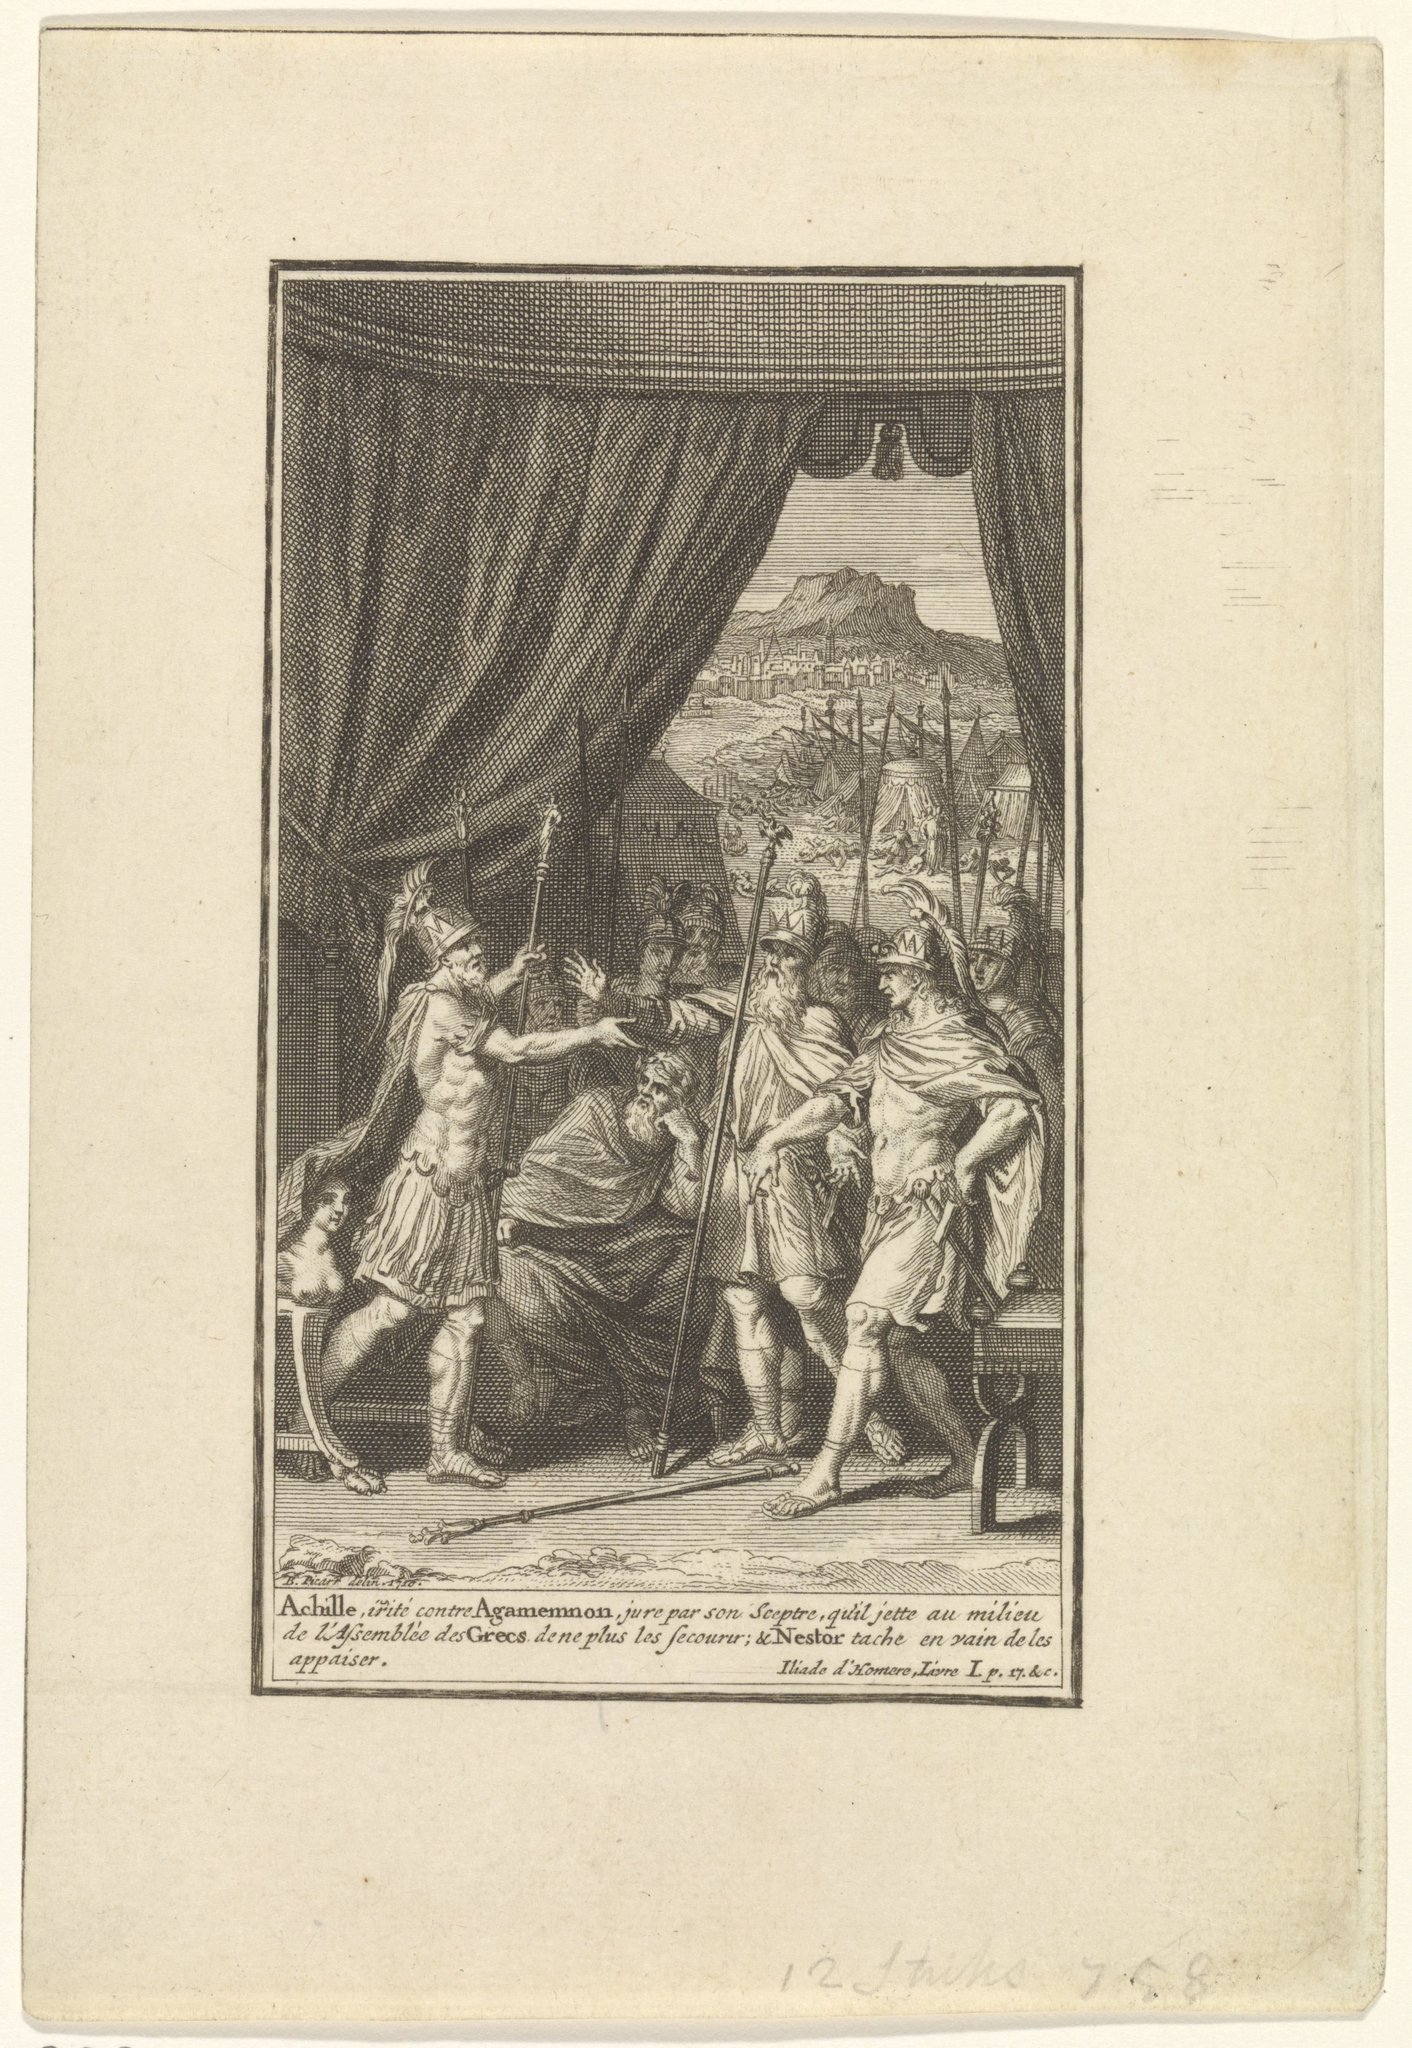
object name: print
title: Twist tussen Achilles en Agamemnon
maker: bernard picart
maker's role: draughtsman, print maker, publisher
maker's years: 1673-1733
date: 1710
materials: paper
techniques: engraving, etching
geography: amsterdam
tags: apollo sends a pestilence into the greek camp, the quarrel about briseis (iliad i), slavery; serfs and enslaved persons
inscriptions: collector's mark: Lugt 2228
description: Achilles beschuldigt koning Agamemnon van hebzucht. De koning eist dan Briseïs op, een slaafgemaakte vrouw die Achilles beminde. De wijze Nestor bemiddelt bij het conflict. Op de achtergrond laat Apollo de pest neerdalen in het Griekse kamp. In de marge een onderschrift in het Frans.